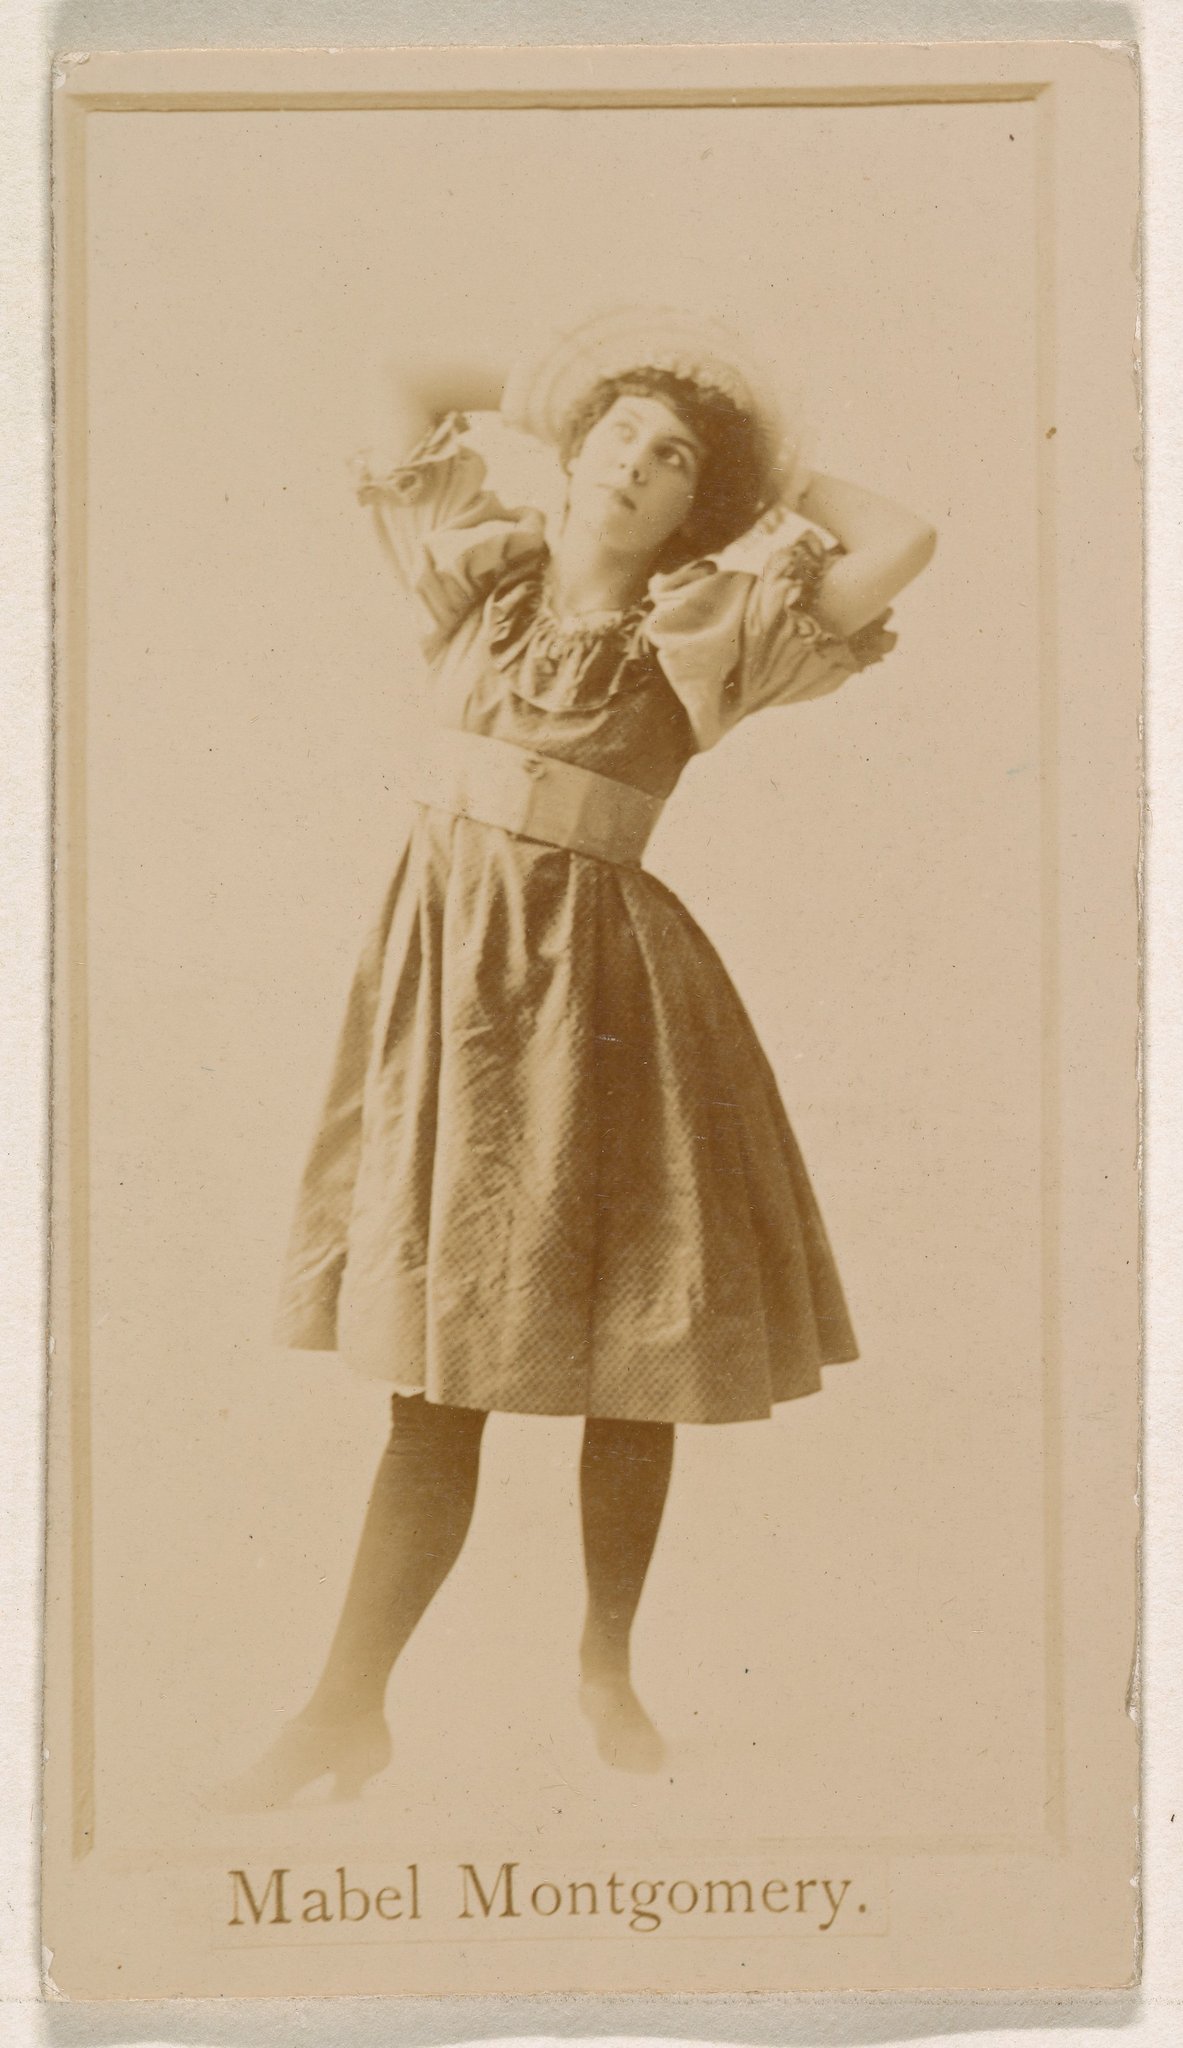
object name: photograph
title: Mabel Montgomery, from the Actresses series (N245) issued by Kinney Brothers to promote Sweet Caporal Cigarettes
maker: kinney brothers tobacco company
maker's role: publisher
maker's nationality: american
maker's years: 1869-2011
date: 1890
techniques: albumen silver print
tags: portraits,women,actresses